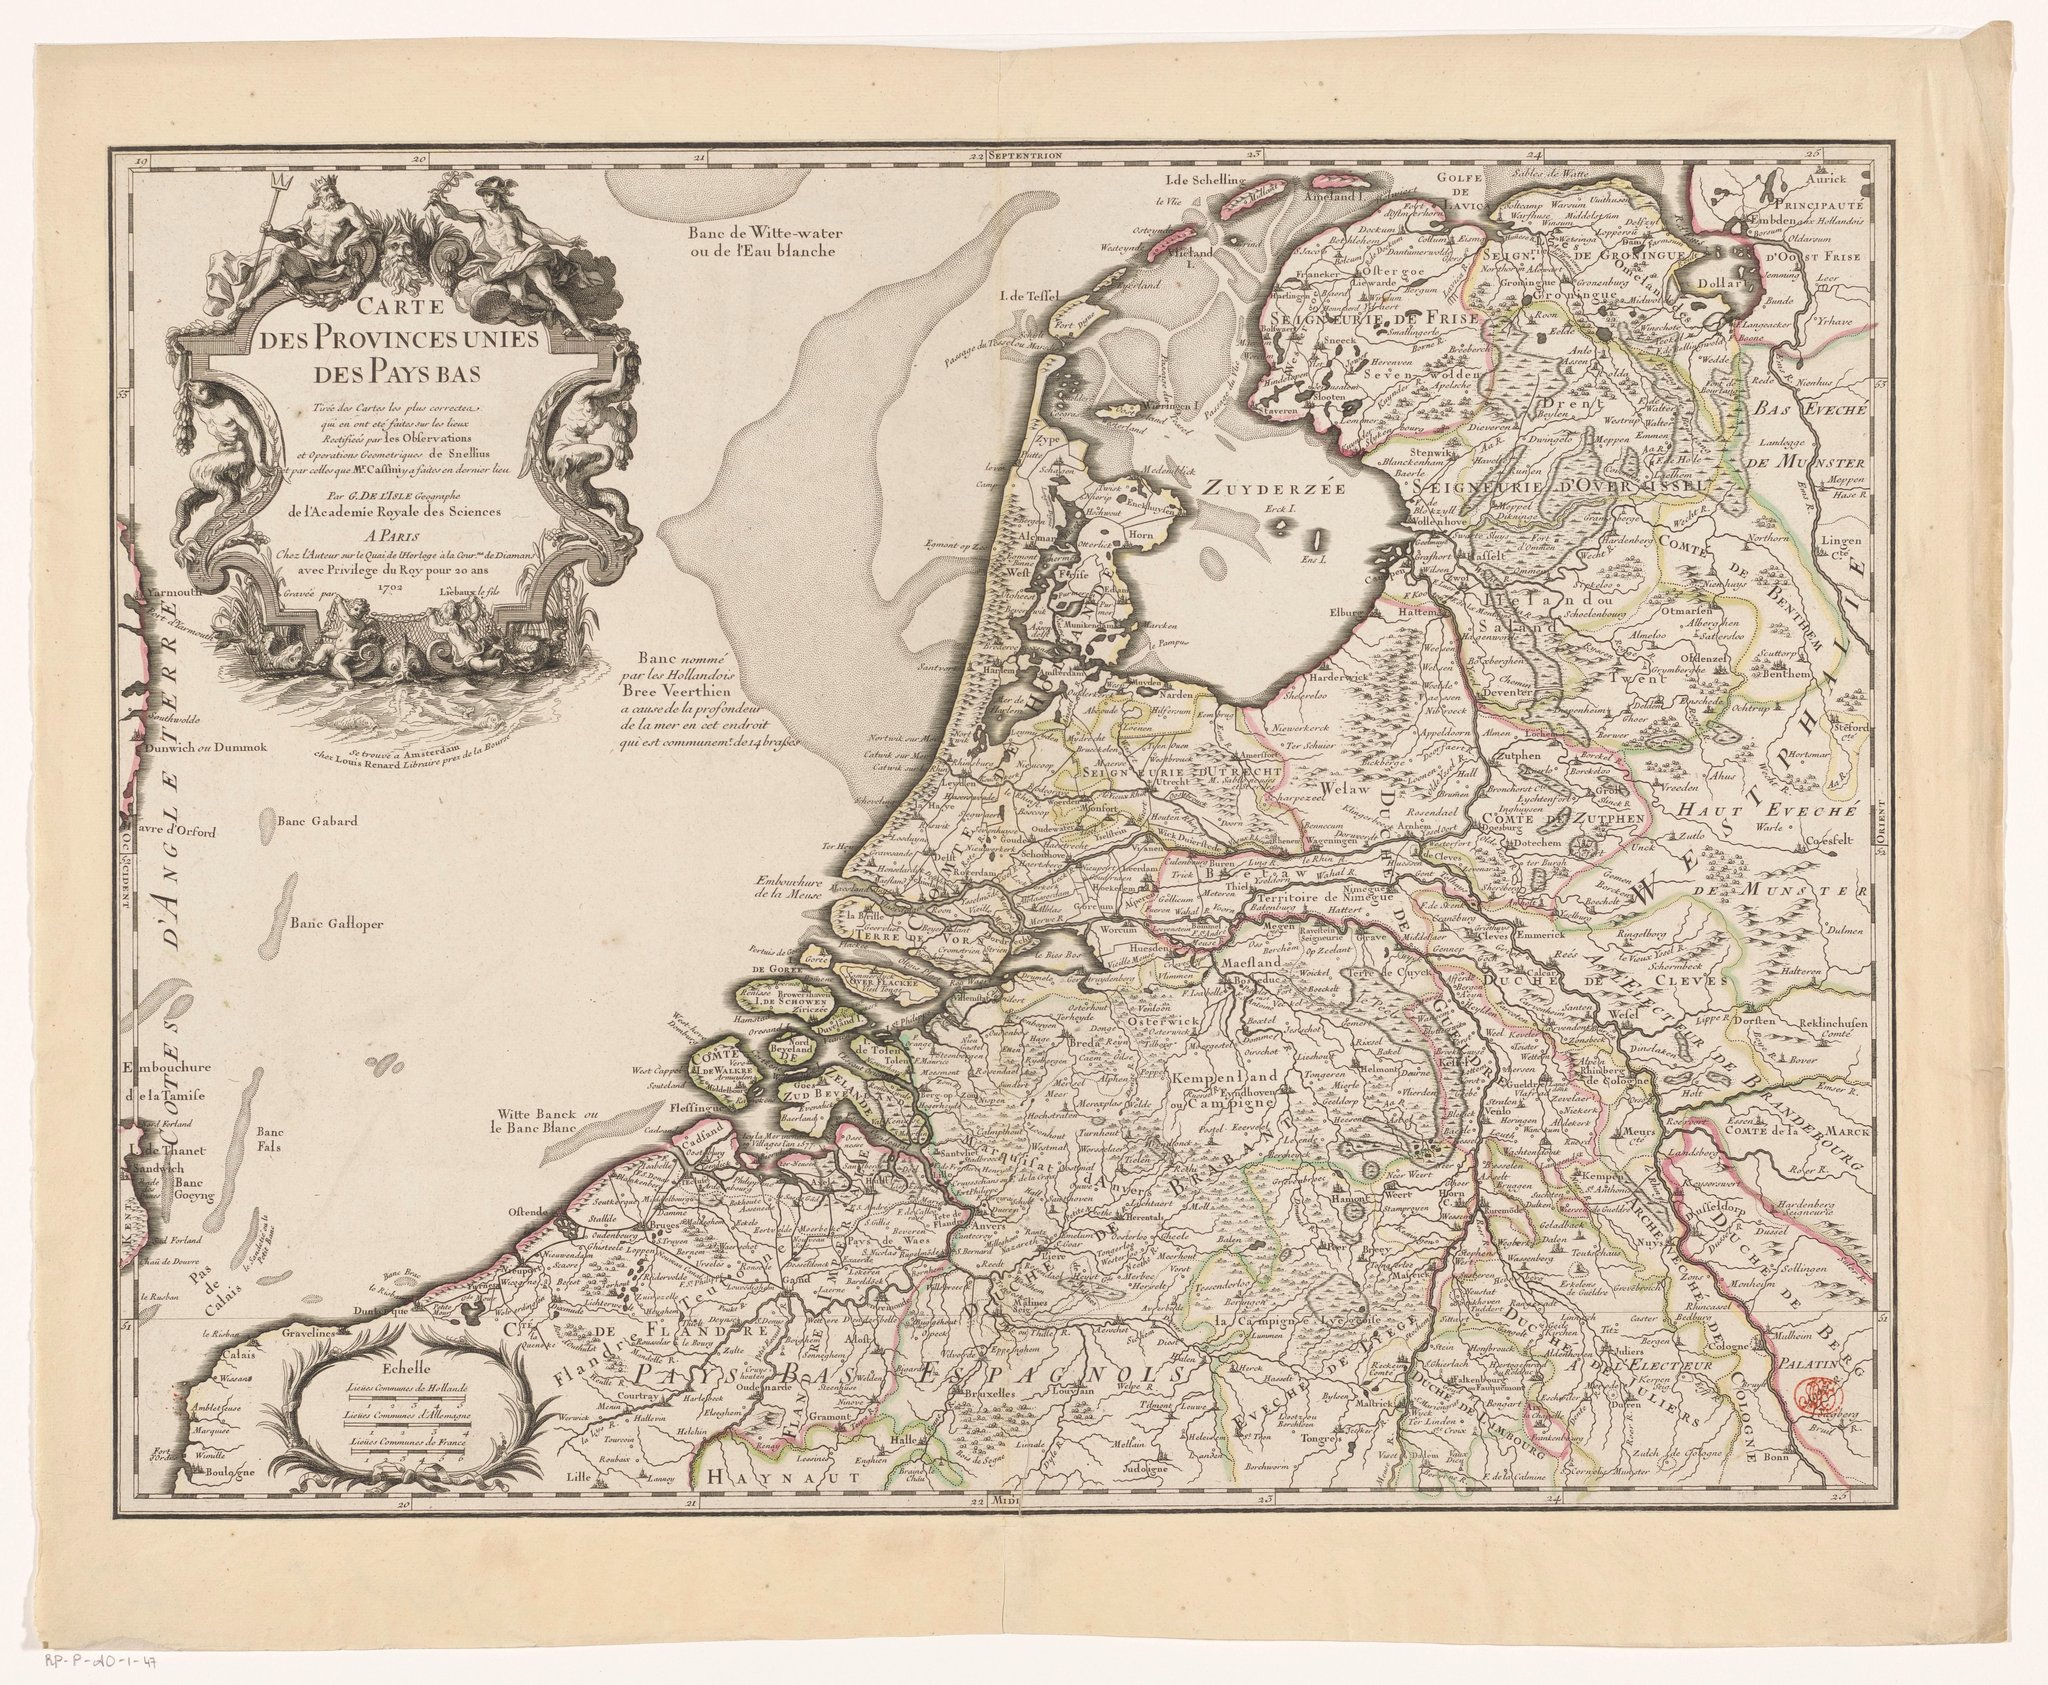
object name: print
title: Carte des Provinces Unies des Pays Bas (...)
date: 1702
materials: paper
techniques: engraving, etching, hand coloring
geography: paris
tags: (story of) neptune (poseidon), triton(s), maps of separate countries or regions, (story of) mercury (hermes), netherlands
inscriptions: collector's mark: Lugt 2228, collector's mark: Lugt 195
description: Linksboven cartouche met titel, om cartouche zijn Neptunus, Mercurius, twee tritons en twee putti afgebeeld. Linksonder schaalstok: Lieües communes de Hollande, Lieües communes d'Allemagne, Lieües communes de France. Gradenverdeling langs randen.